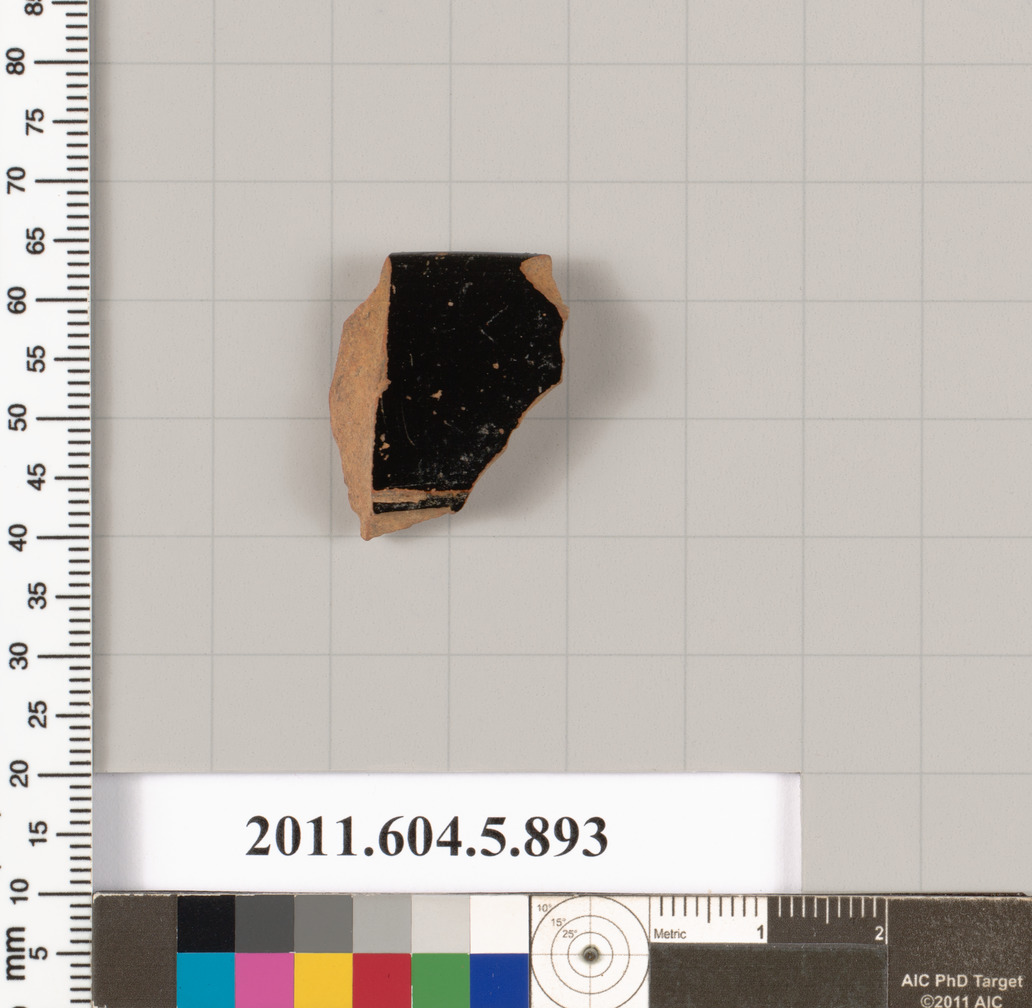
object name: kylix fragment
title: Terracotta rim fragment of a kylix (drinking cup)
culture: greek, attic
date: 600-401 BCE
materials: terracotta